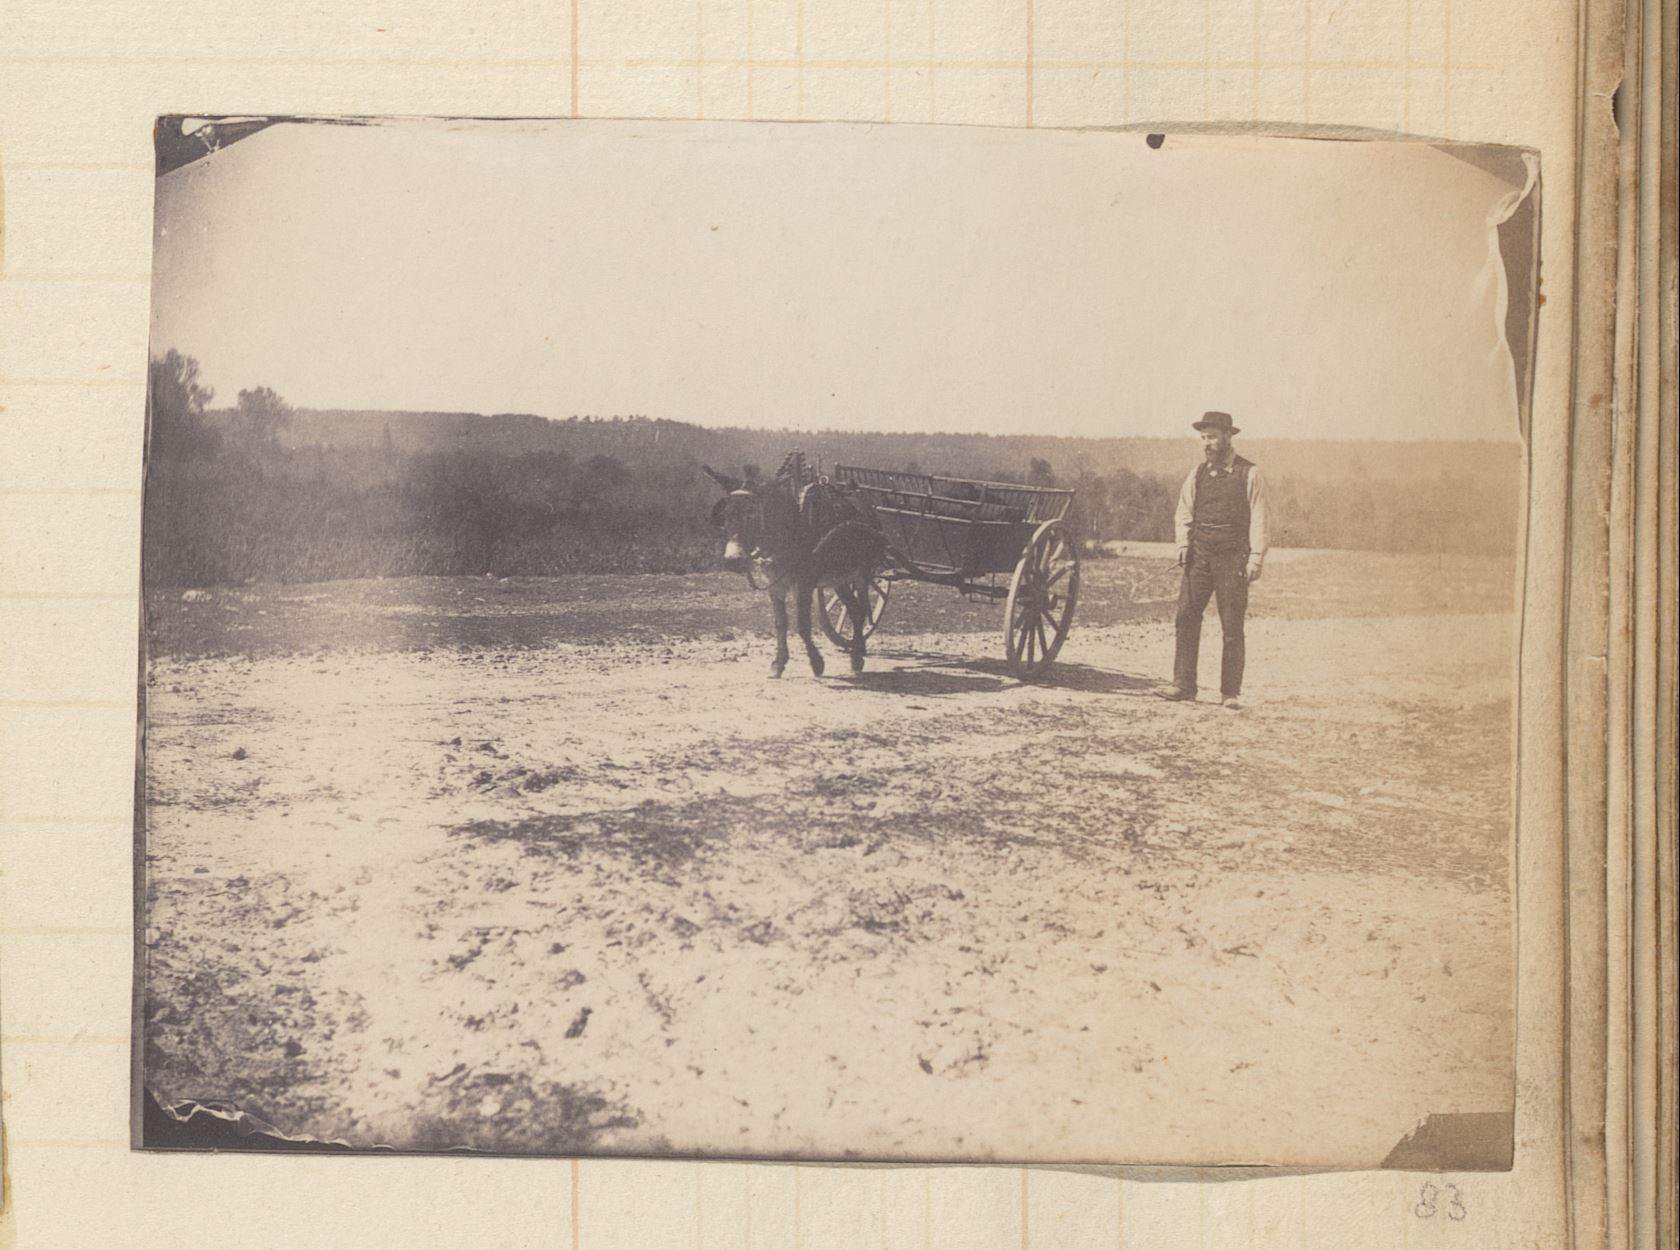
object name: photograph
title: Ezelkar en een lopende man op een veldweg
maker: Anonymous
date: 1880-1900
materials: paper, photographic support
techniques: salted paper print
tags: two-wheeled, animal-drawn vehicle